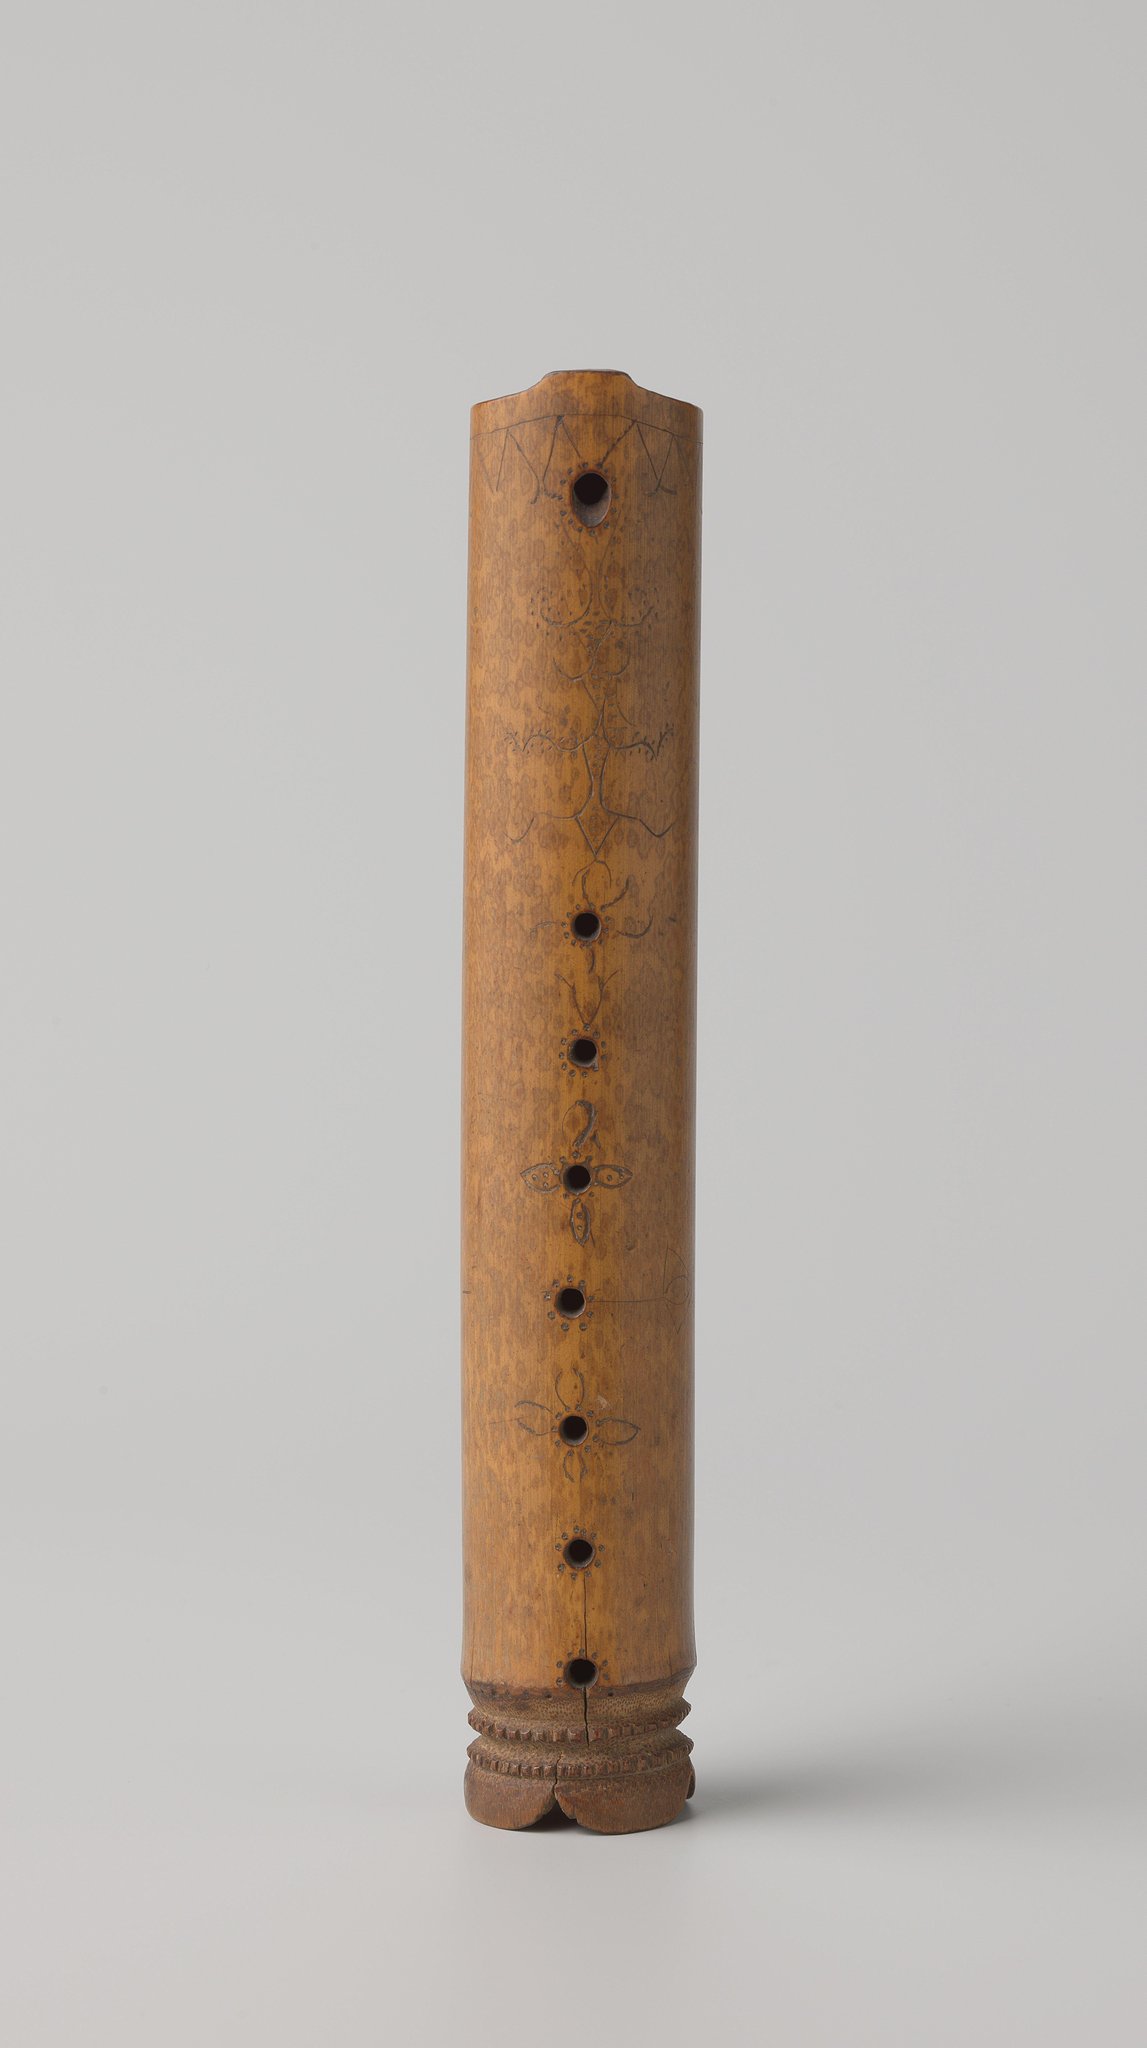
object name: musical instrument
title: Duct flute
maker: Anonymous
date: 1800-1890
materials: reed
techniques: riet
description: Rieten fluit met zeven gaten. Horend bij twee fluiten (BK-NM-11430-67-A t/m BK-NM-11430-67-C).